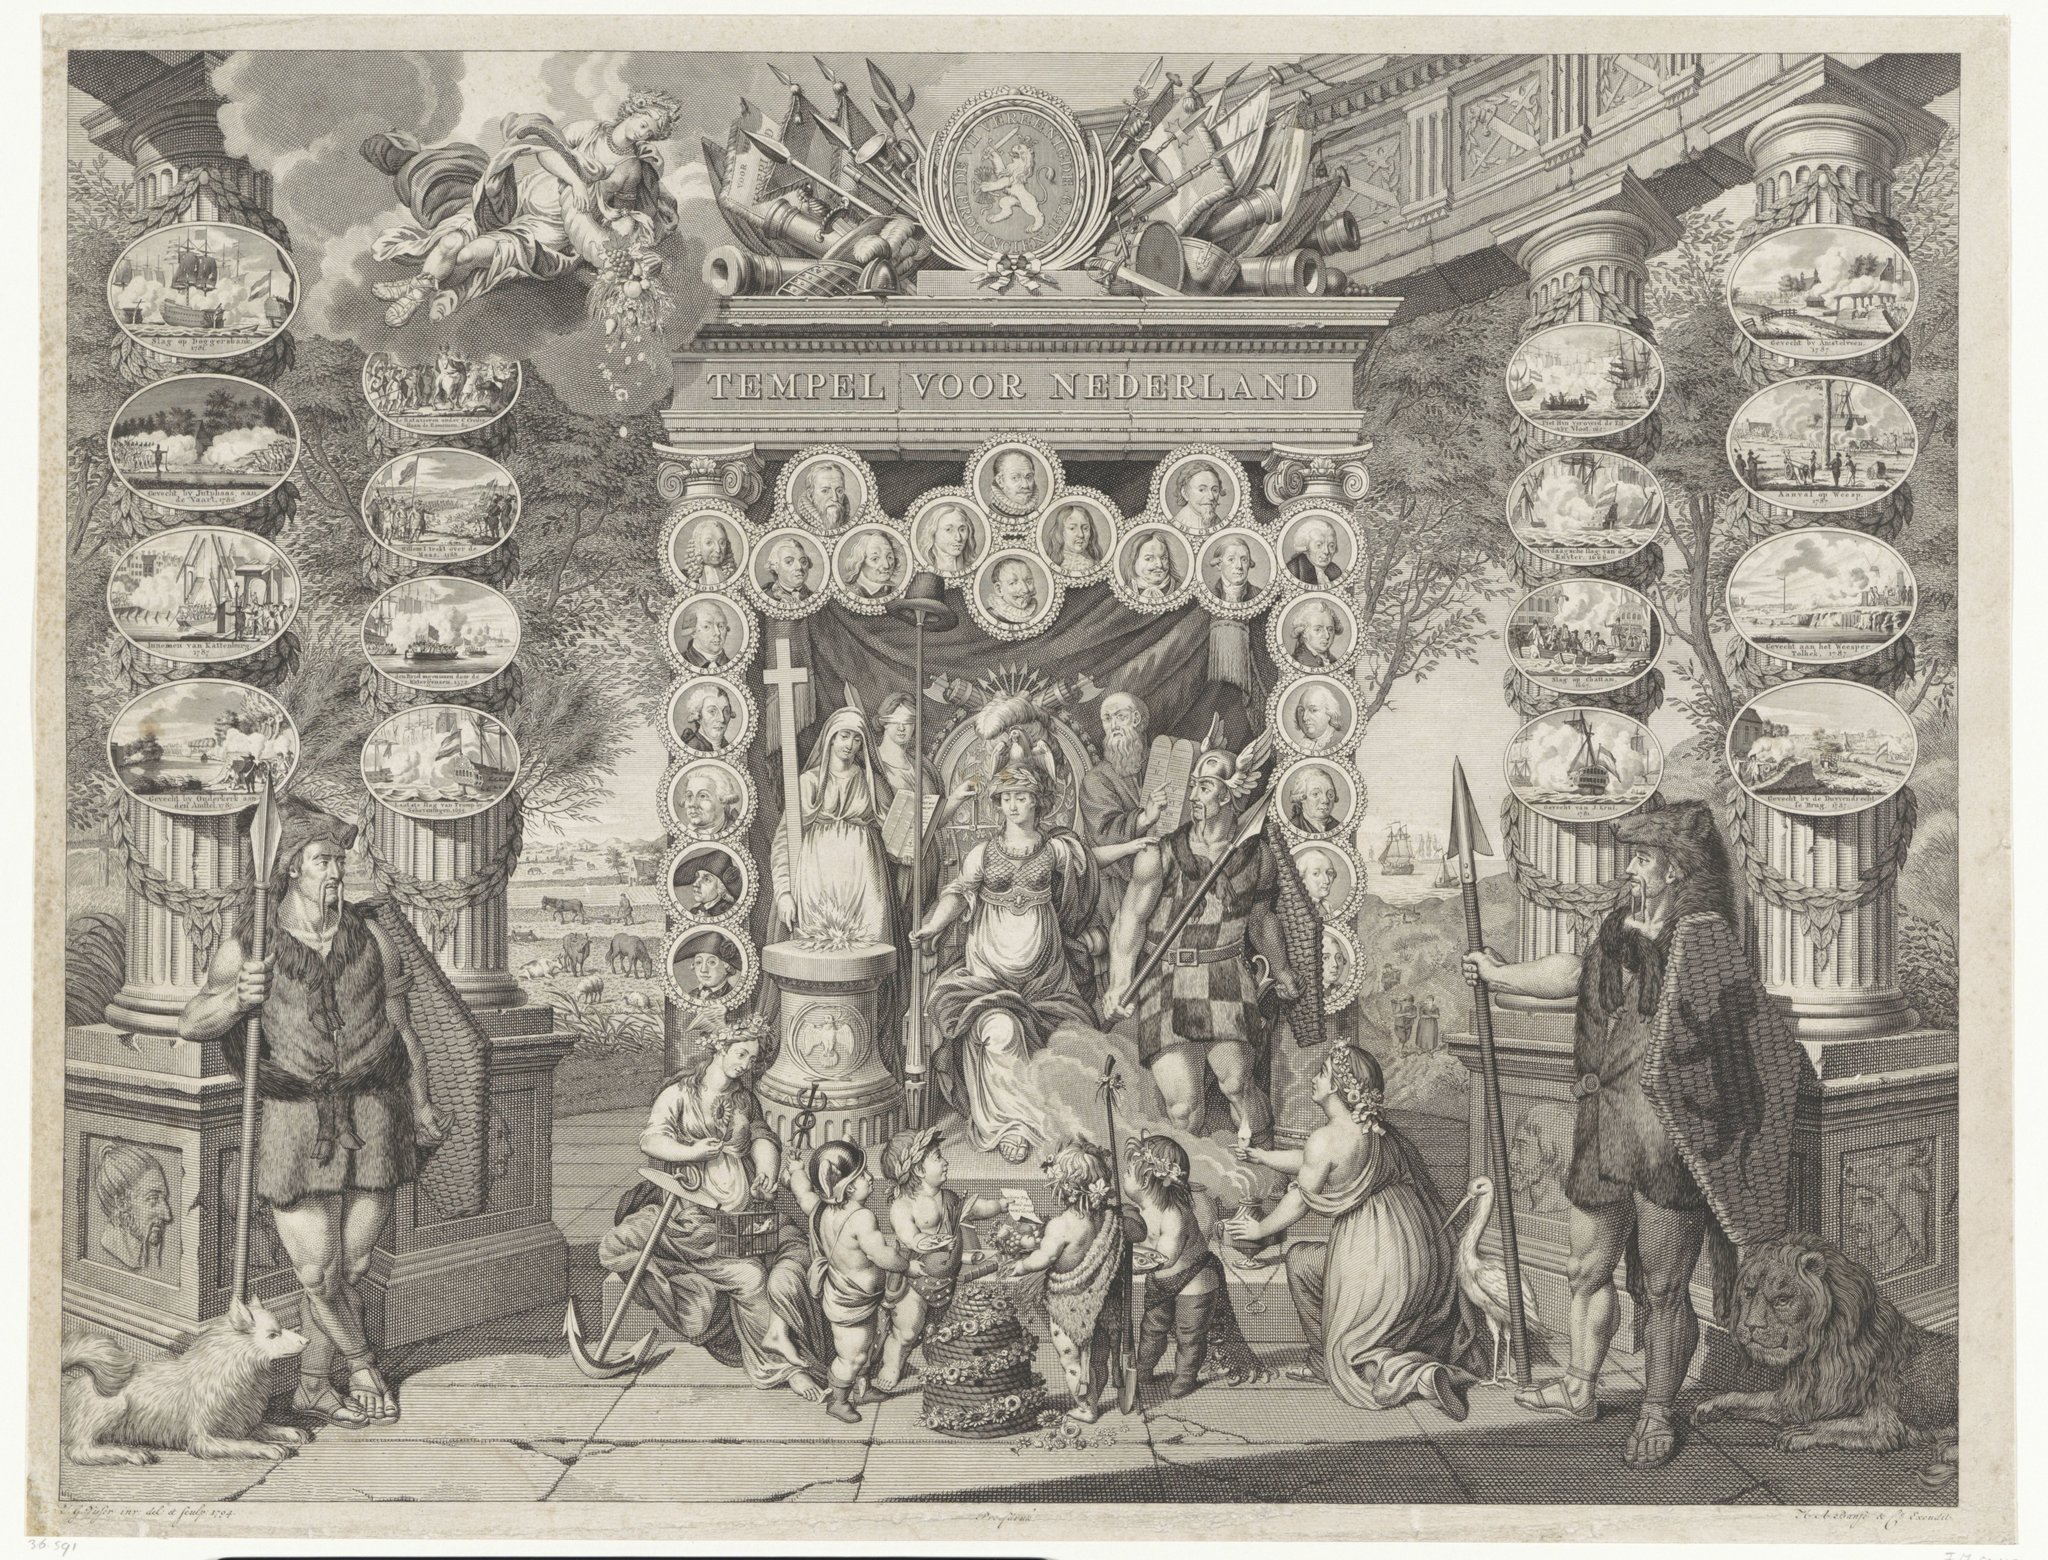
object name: print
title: Allegorische voorstelling op de vrijheid en de godsdienst volgens de patriotten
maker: jan gerritsz. visser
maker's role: print maker, publisher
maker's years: 1745-1821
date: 1794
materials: paper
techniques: engraving, etching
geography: amsterdam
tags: freedom, liberty; 'libertà' (ripa) (+ allegorical scene, i.e. two or more personifications involved in an action), column, pillar ~ architecture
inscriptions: collector's mark: Lugt 2228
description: Een allegorische vrouwenfiguur met een vrijheidshoed-op-stok- zit in een tempel, met een omlijsting van portretten in medaillons. Links en rechts zijn dit portretten van patriotten uit 1786-1787 en bovenaan tien portretten van personen uit de zestiende en de zeventiende eeuw. Voor de pilaren aan weerszijden een batavier, een met een leeuw en de ander met een keeshond. Op de pilaren hangen o.a. voorstellingen van de Slag bij Doggersbank en gevechten bij Amsterdam in 1787.